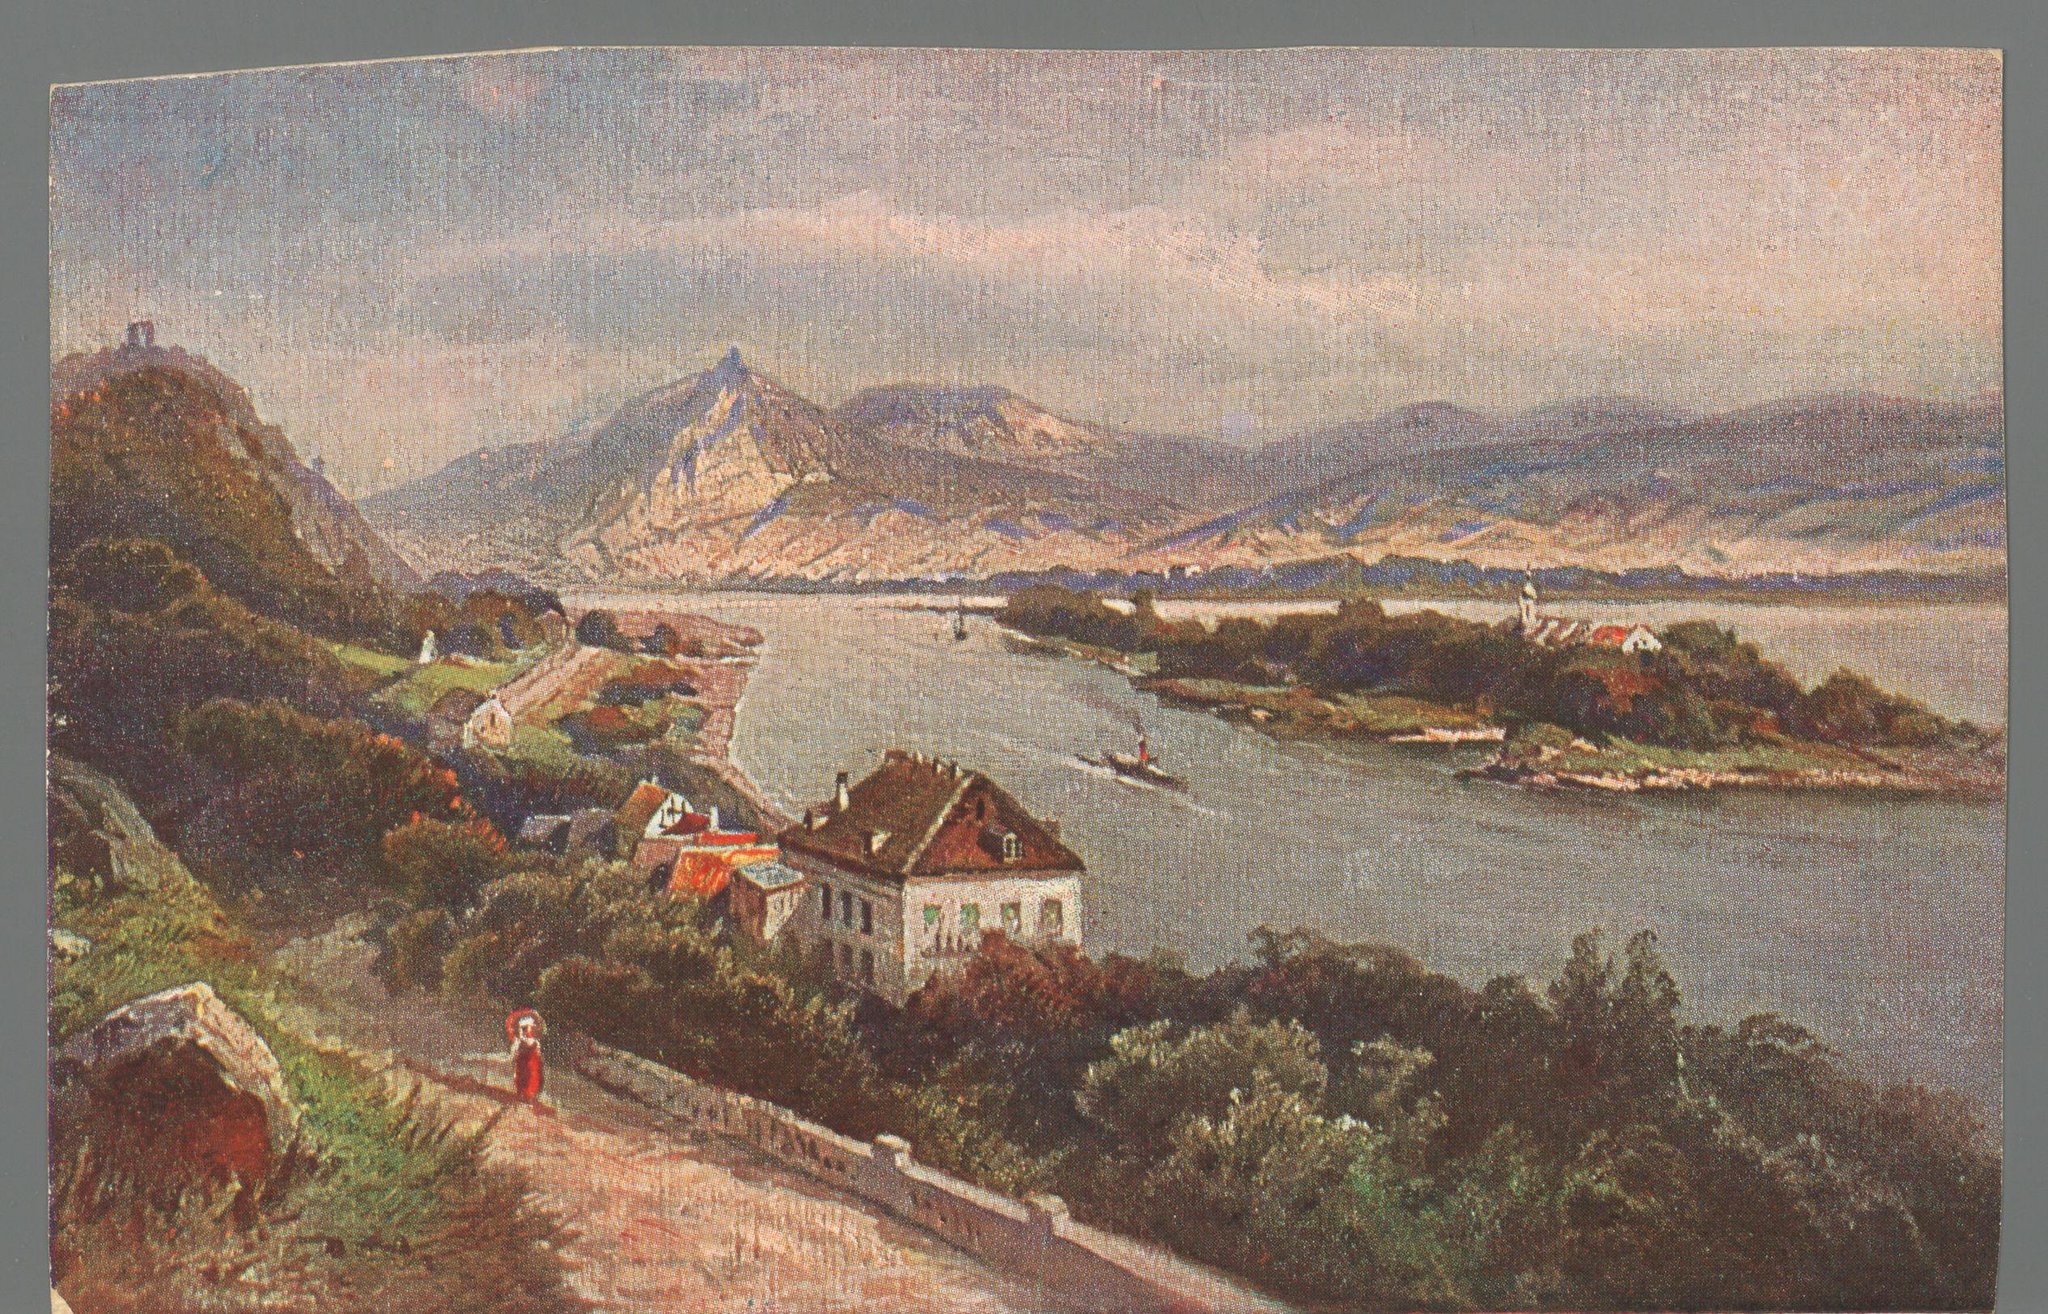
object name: ansichtkaart, prentbriefkaart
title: Astudin-Karten vom Rhein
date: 1905-1930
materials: cardboard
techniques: color autotype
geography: cologne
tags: city-view, and landscape with man-made constructions, river